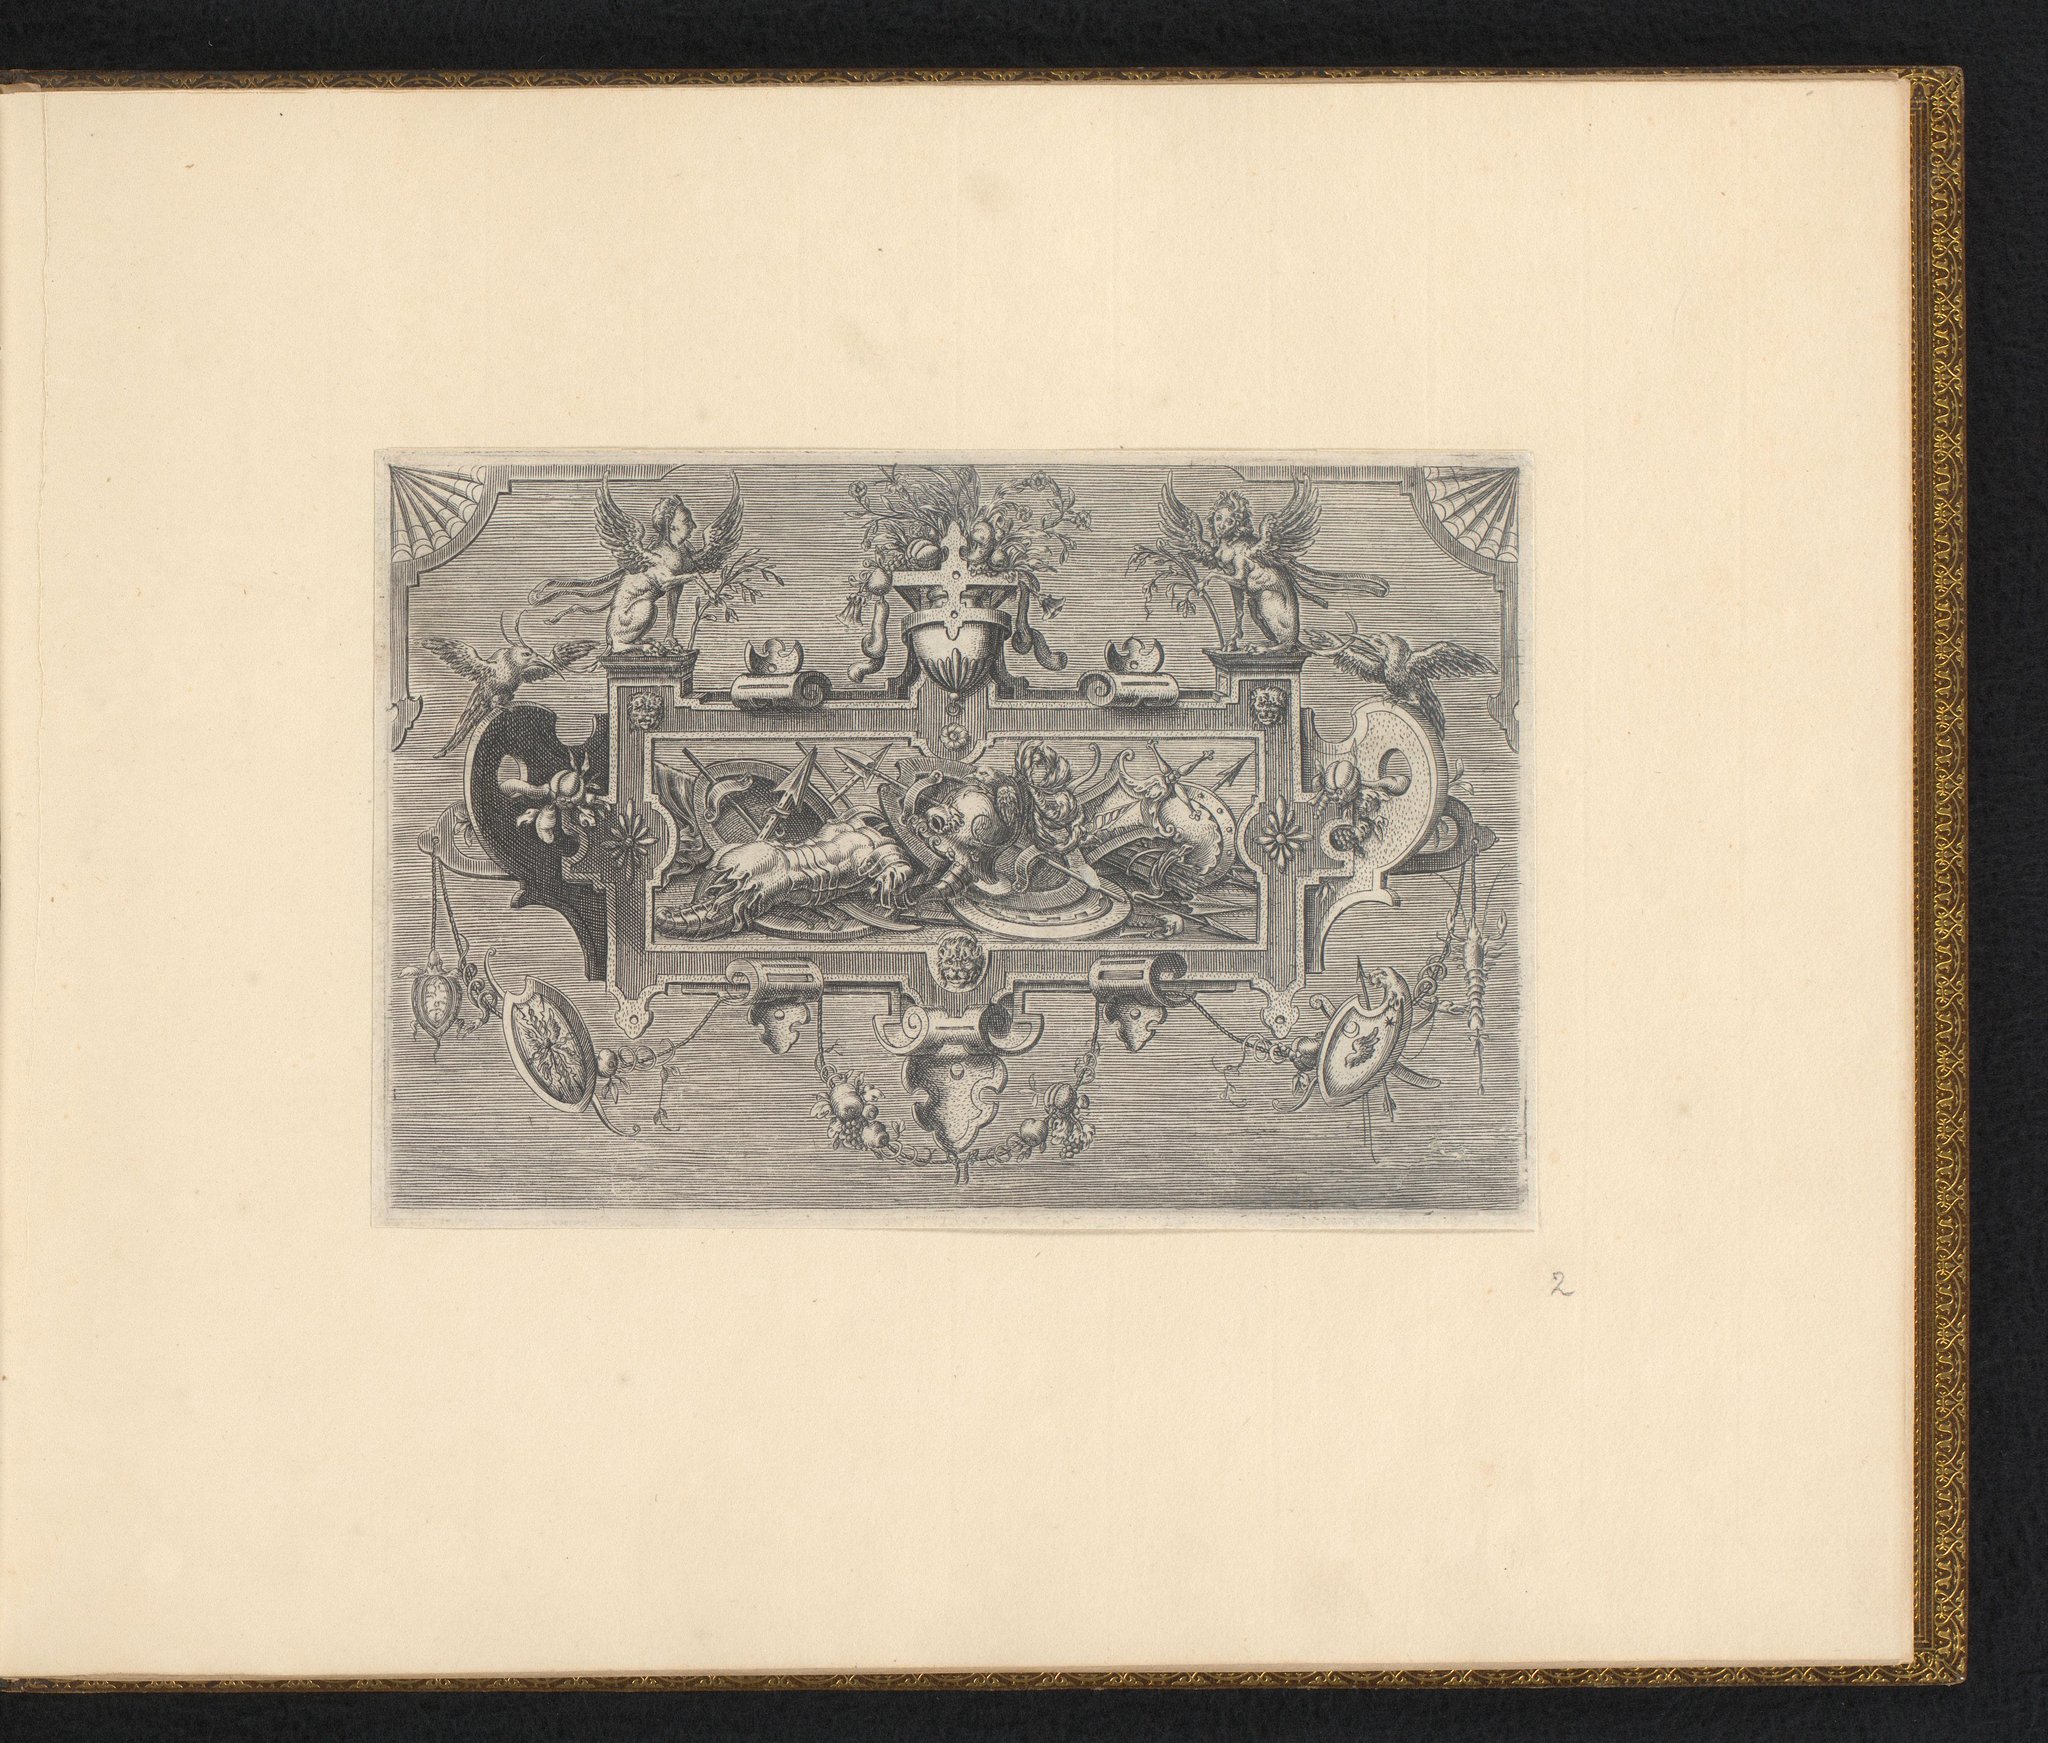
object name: ornament print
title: Veelderhande cierlijcke compertementen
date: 1564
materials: paper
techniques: engraving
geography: amsterdam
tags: sphinx (lion/woman); 'sfinge' (ripa) - aa - female human figure, trophy, i.e.: decorative arrangement of symbolic or typical objects ~ ornament, tortoises, turtles, scrollwork, strapwork ~ ornament, ornament ~ cartouche, crustaceans: lobster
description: Cartouche met een wapentrofee in een omlijsting van rolwerk. Op de cartouche zit links en rechts een sfinx. Tussen hen in een grote vaas met bloemen en fruit. Onderaan een wapenschild met boog en een wapenschild met pijl. Links en rechts daarvan een schildpad en een kreeft. De prent maakt deel uit van een album.